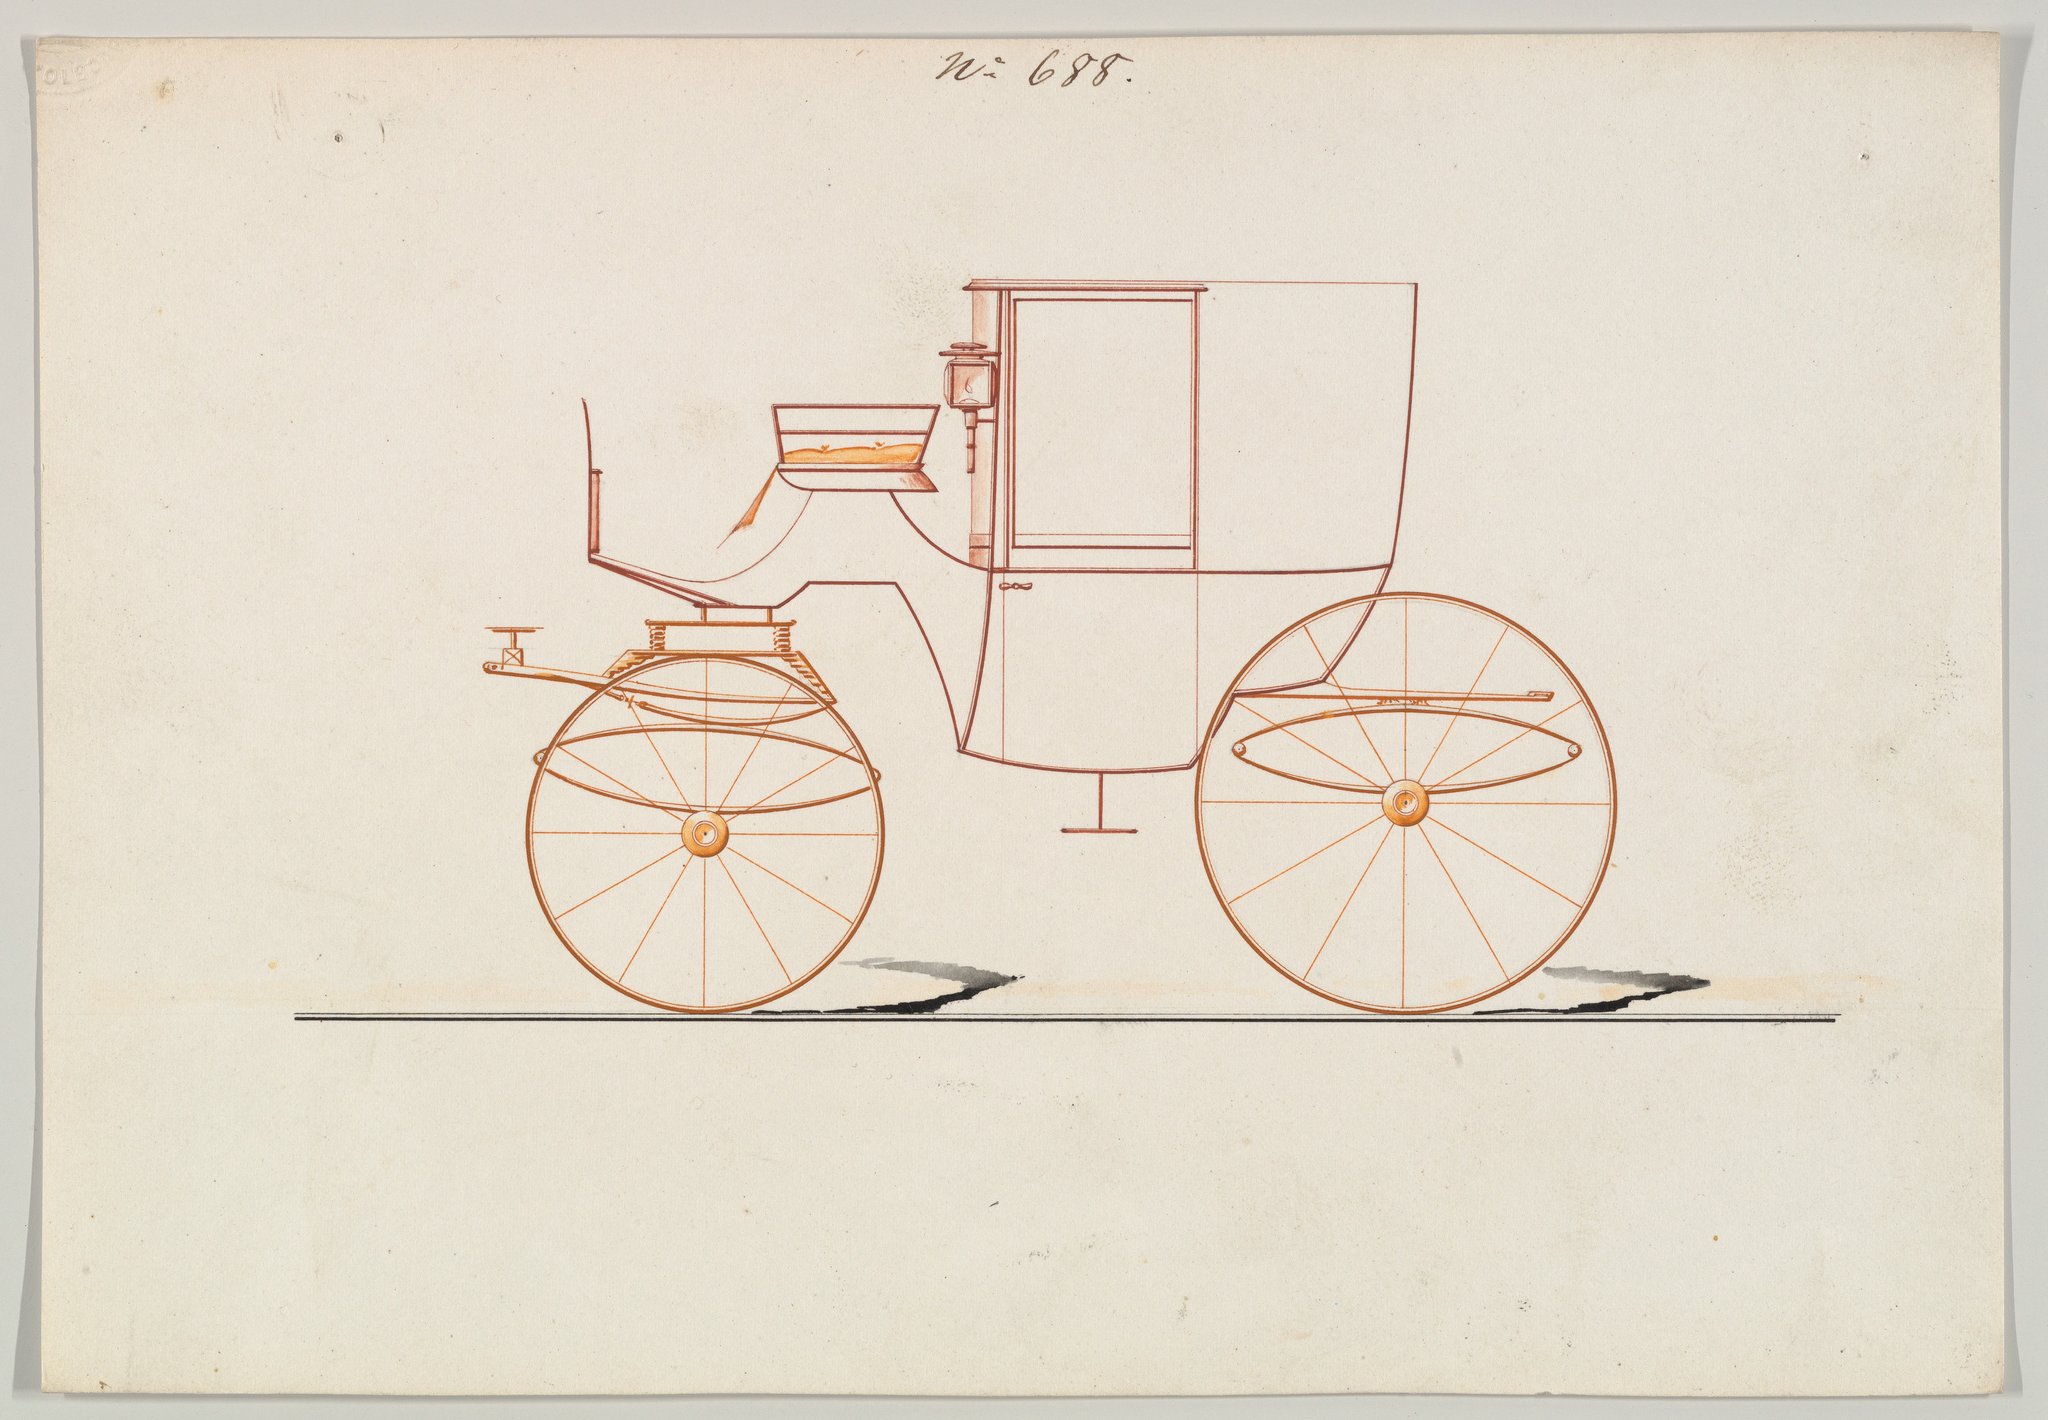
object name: drawing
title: Coupé # 688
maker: brewster & co.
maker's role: manufacturer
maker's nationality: american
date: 1850-1870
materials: watercolor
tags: carriages